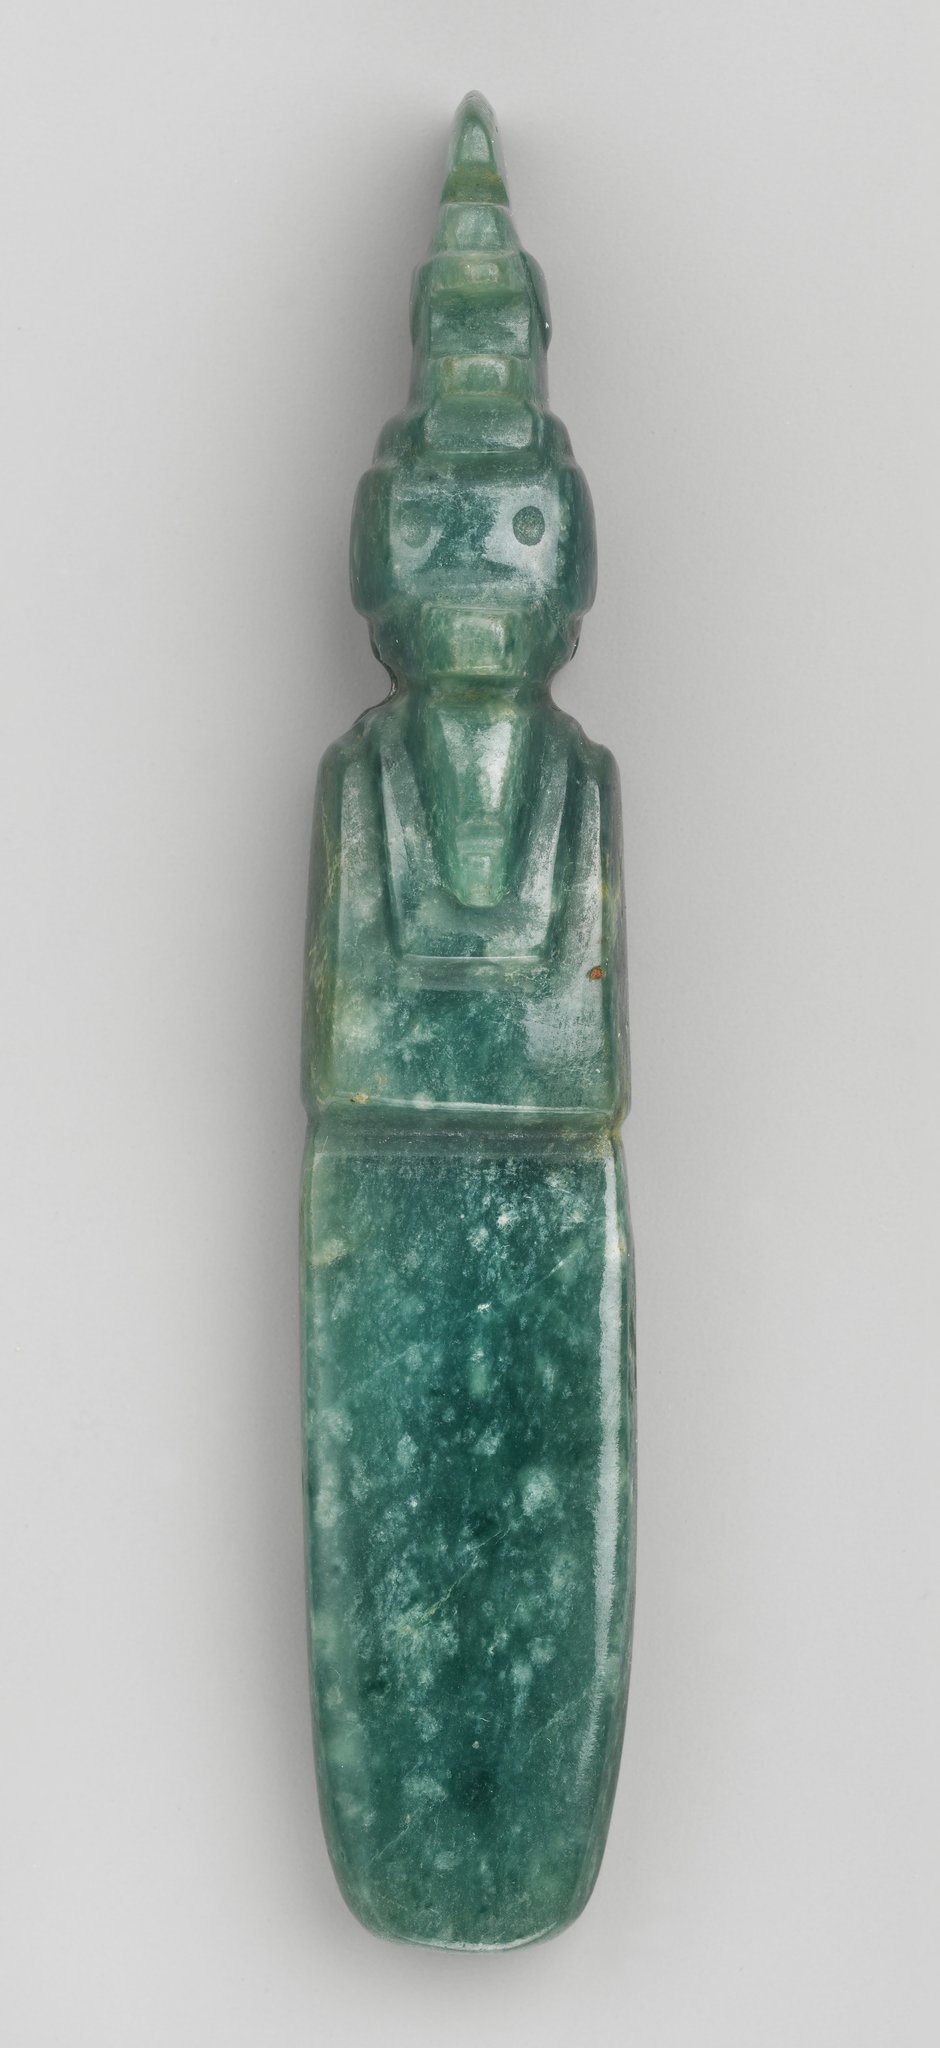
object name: pendant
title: Celt pendant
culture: guanacaste-nicoya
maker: greater nicoya or central region artitst(s)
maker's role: artist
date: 1-500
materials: jade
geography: costa rica